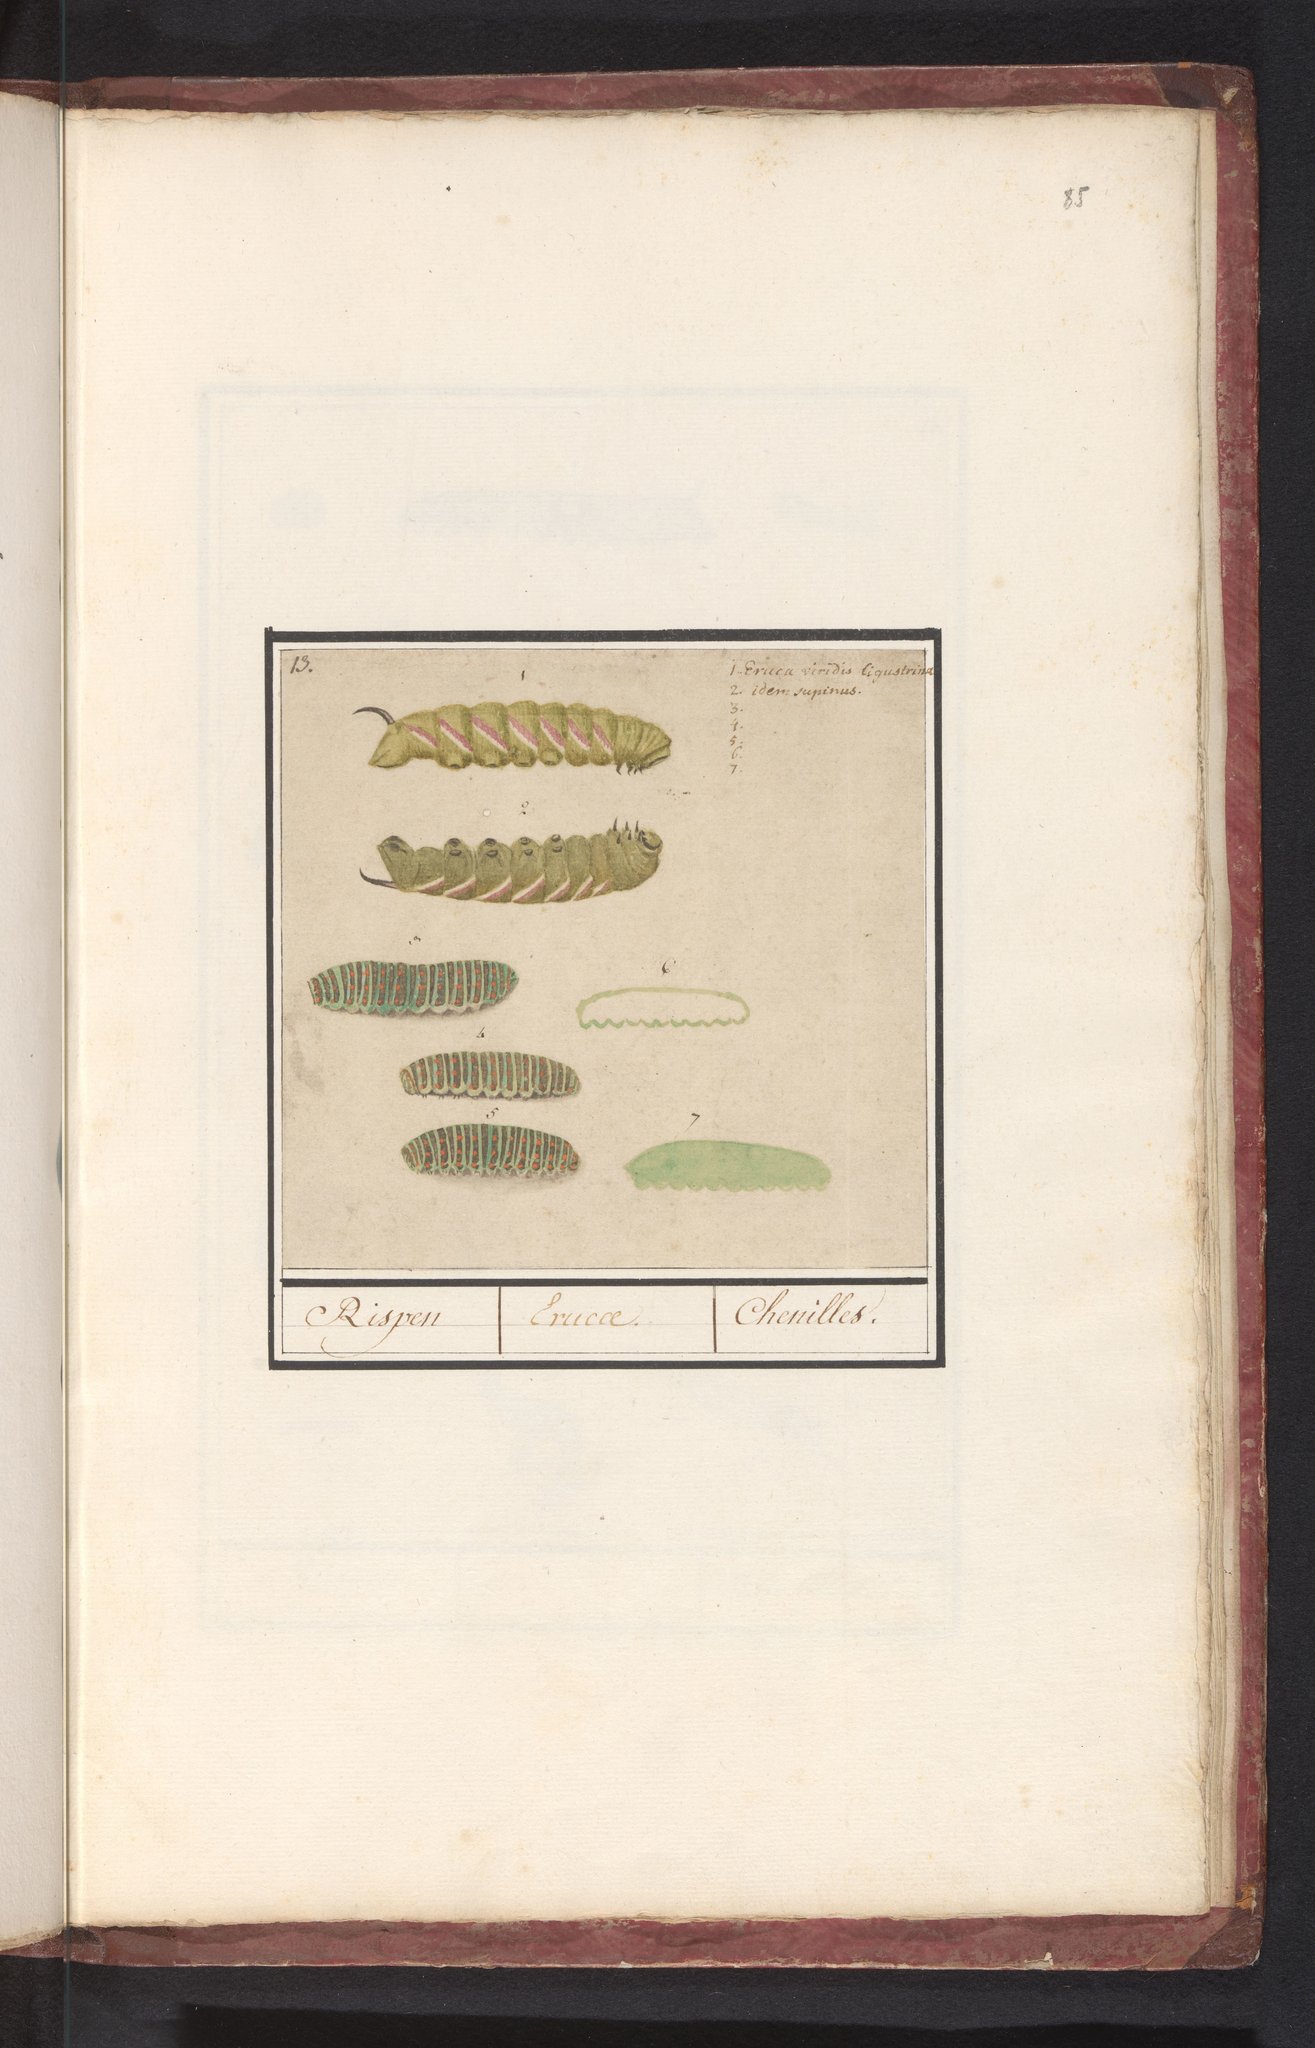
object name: drawing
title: Rispen / Erucae. / Chenilles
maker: anselmus boëtius de boodt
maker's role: draughtsman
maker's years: 1550-1632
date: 1596-1610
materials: chalk, paint, ink, paper, pencil, watercolor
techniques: brush, pen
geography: prague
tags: insects: caterpillar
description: Blad met verschillende rupsen, genummerd 1-7. Rechtsboven twee namen in het Latijn. Genummerd linksboven: 13. Onderdeel van het zesde album met tekeningen van vissen, schelpen en insekten. Zesde van twaalf albums met tekeningen van dieren, vogels en planten bekend rond 1600, gemaakt in opdracht van keizer Rudolf II. Met toelichting in Nederlands, Latijn en Frans.